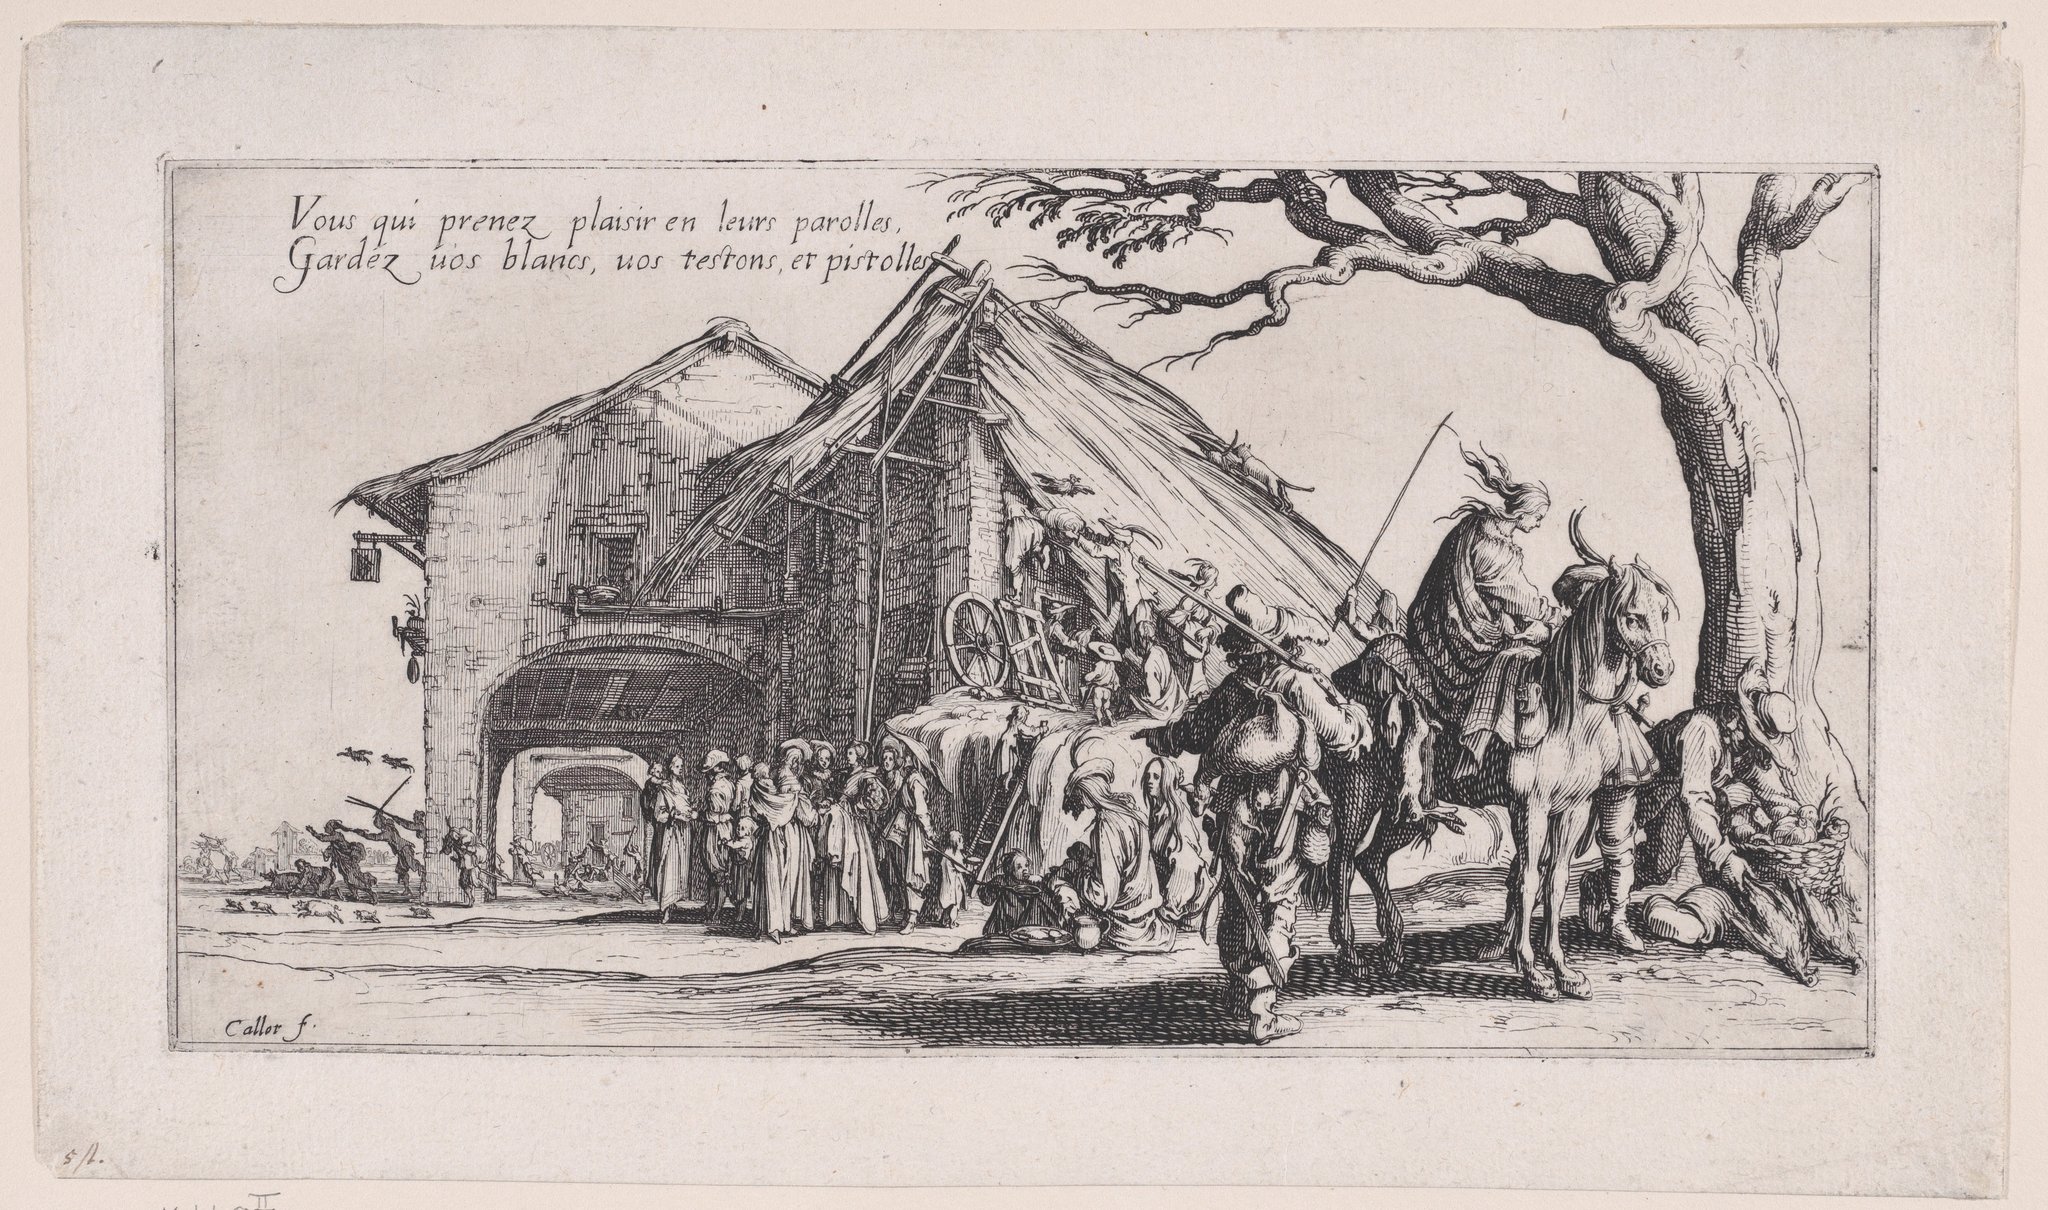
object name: print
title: La Halte des Bohémiens: Les Diseuses de Bonne Aventure (The Gypsy Stopover: The Fortune Tellers), from Le Bohémiens, série appelée aussi Les Égyptiens, La Marche des Bohémiens, La Vie Errante des Bohémiens, Les Marches Égyptiennes (The Gypsies, series also called The Egyptians, The Gypsy Troops, The Wandering Lives of Gypsies, The Egyptian Troops)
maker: jacques callot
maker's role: artist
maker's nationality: french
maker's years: 1592-1635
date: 1601-1633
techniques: engraving, etching